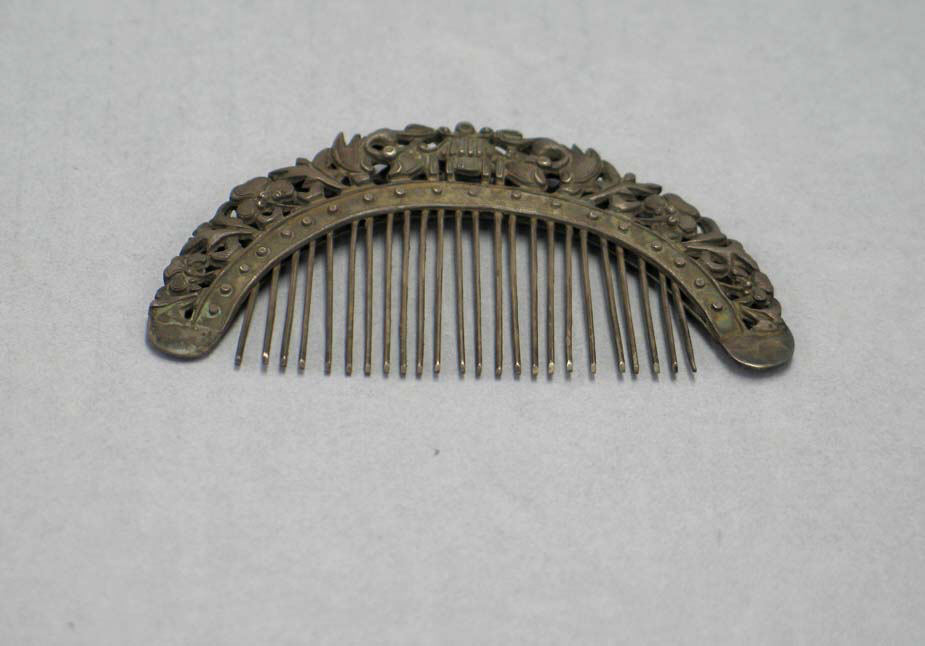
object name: comb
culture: chinese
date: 960-1644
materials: silver